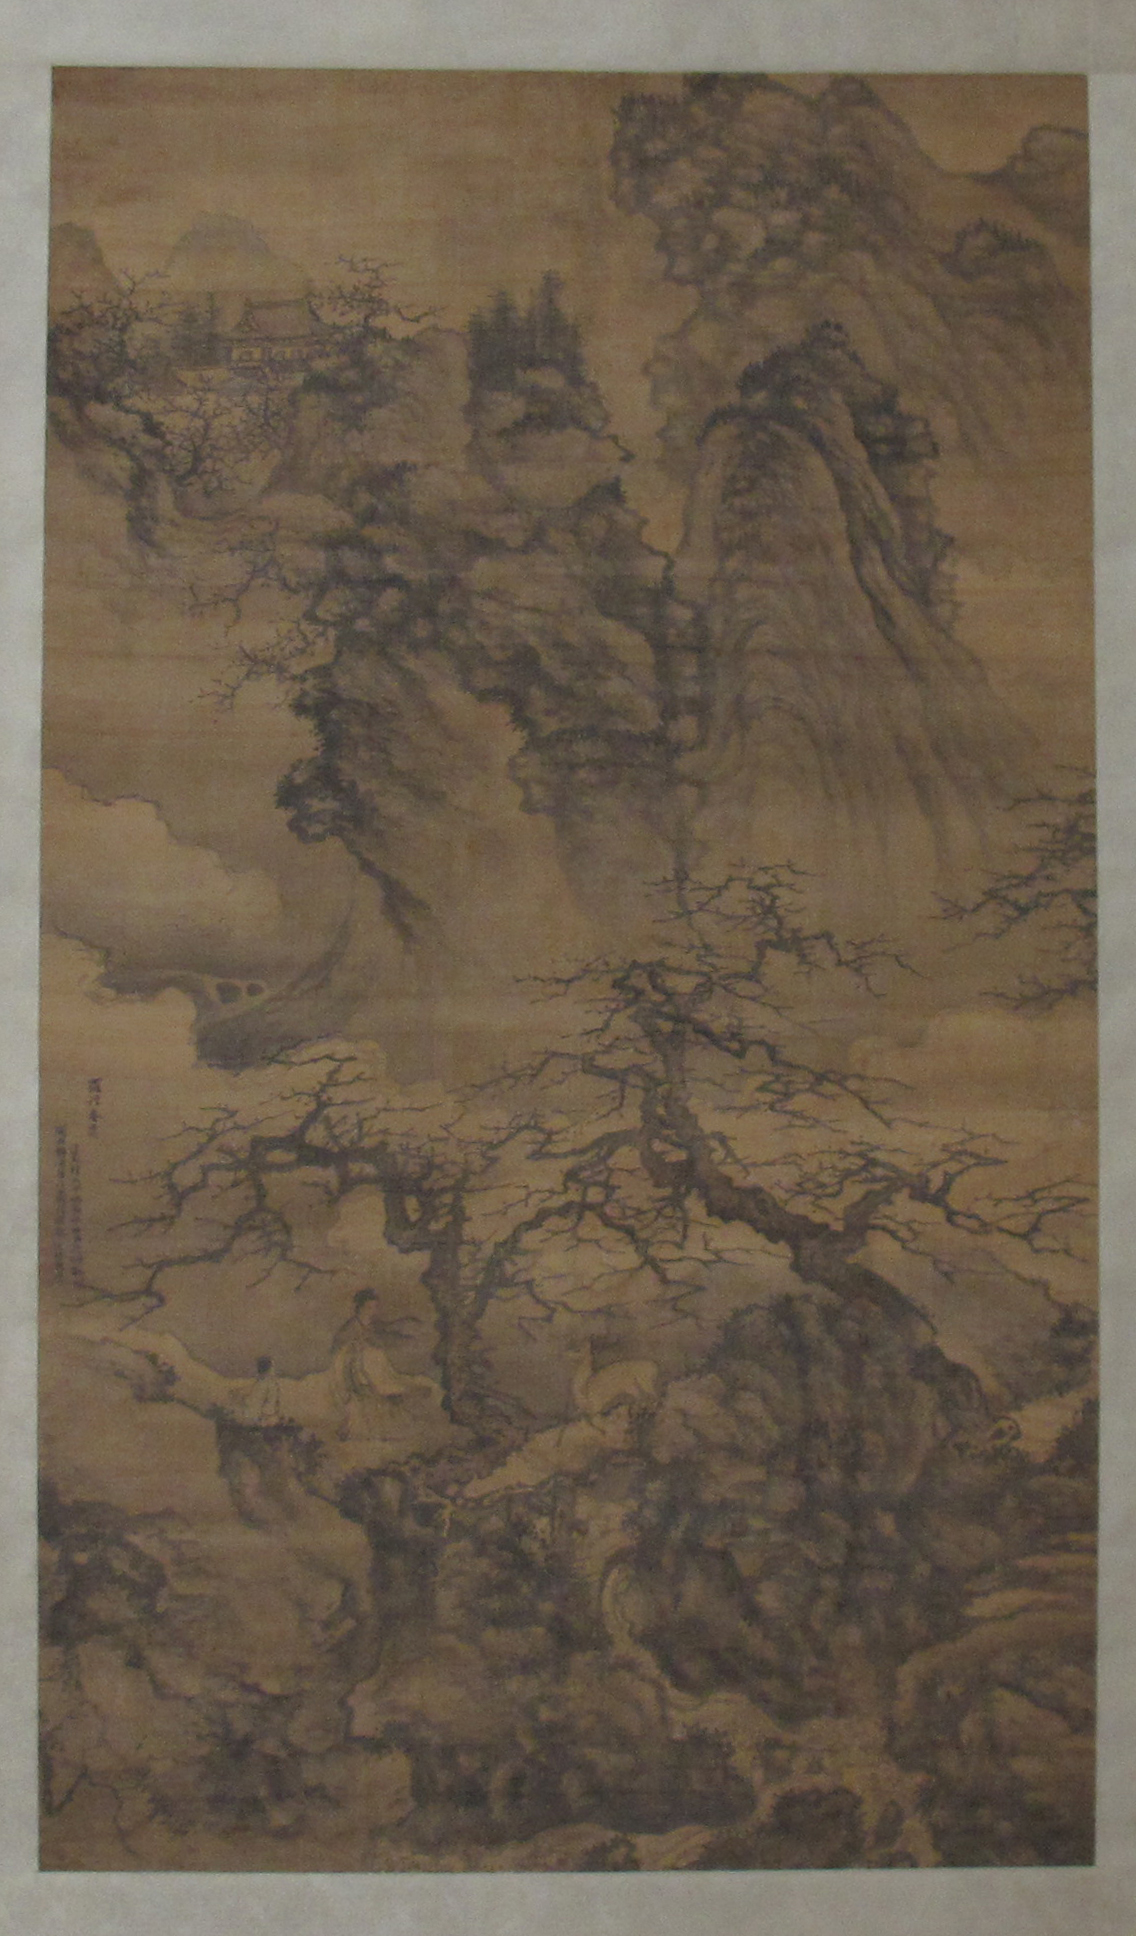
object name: hanging scroll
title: Spring Landscape with Plum Blossoms, Scholar and Deer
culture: chinese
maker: xie shichen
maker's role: artist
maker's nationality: chinese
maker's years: 1487-1567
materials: ink, silk